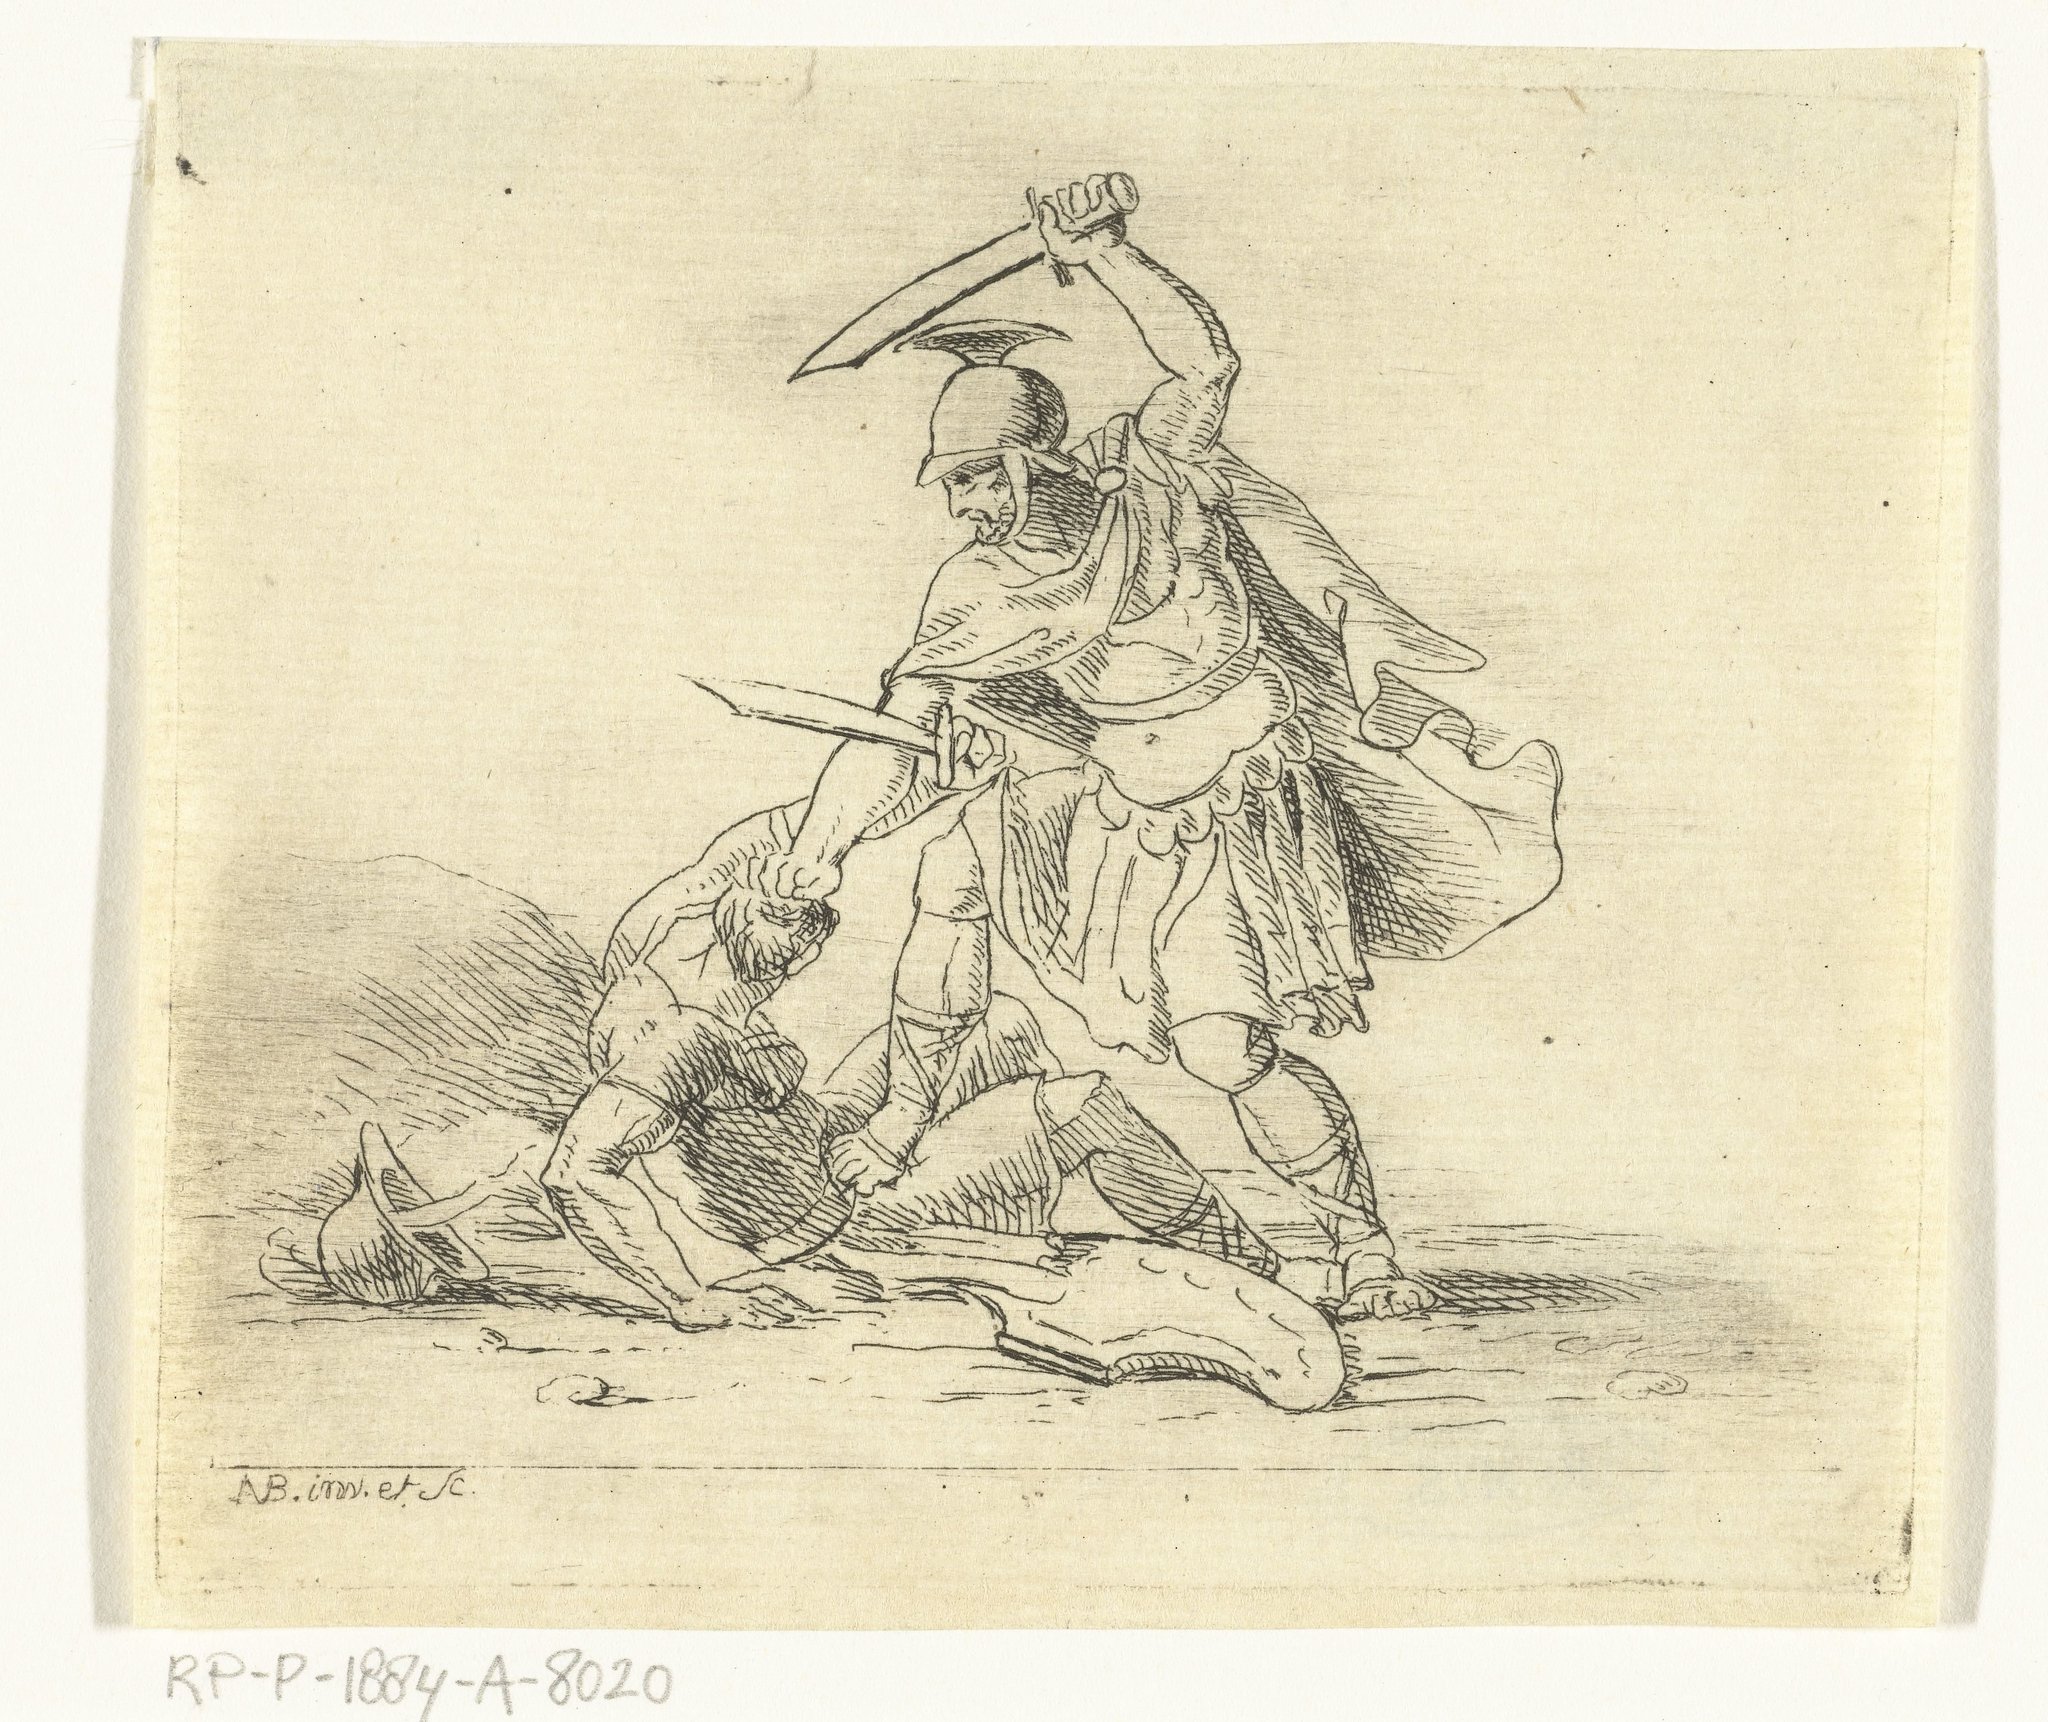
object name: print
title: Twee Romeinse soldaten met elkaar in gevecht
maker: antonis aloisius emanuel van bedaff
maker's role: print maker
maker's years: 1787-1829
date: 1797-1829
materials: paper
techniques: etching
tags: private soldier, hand-to-hand fighting (~ battle)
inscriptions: collector's mark: Lugt 2228